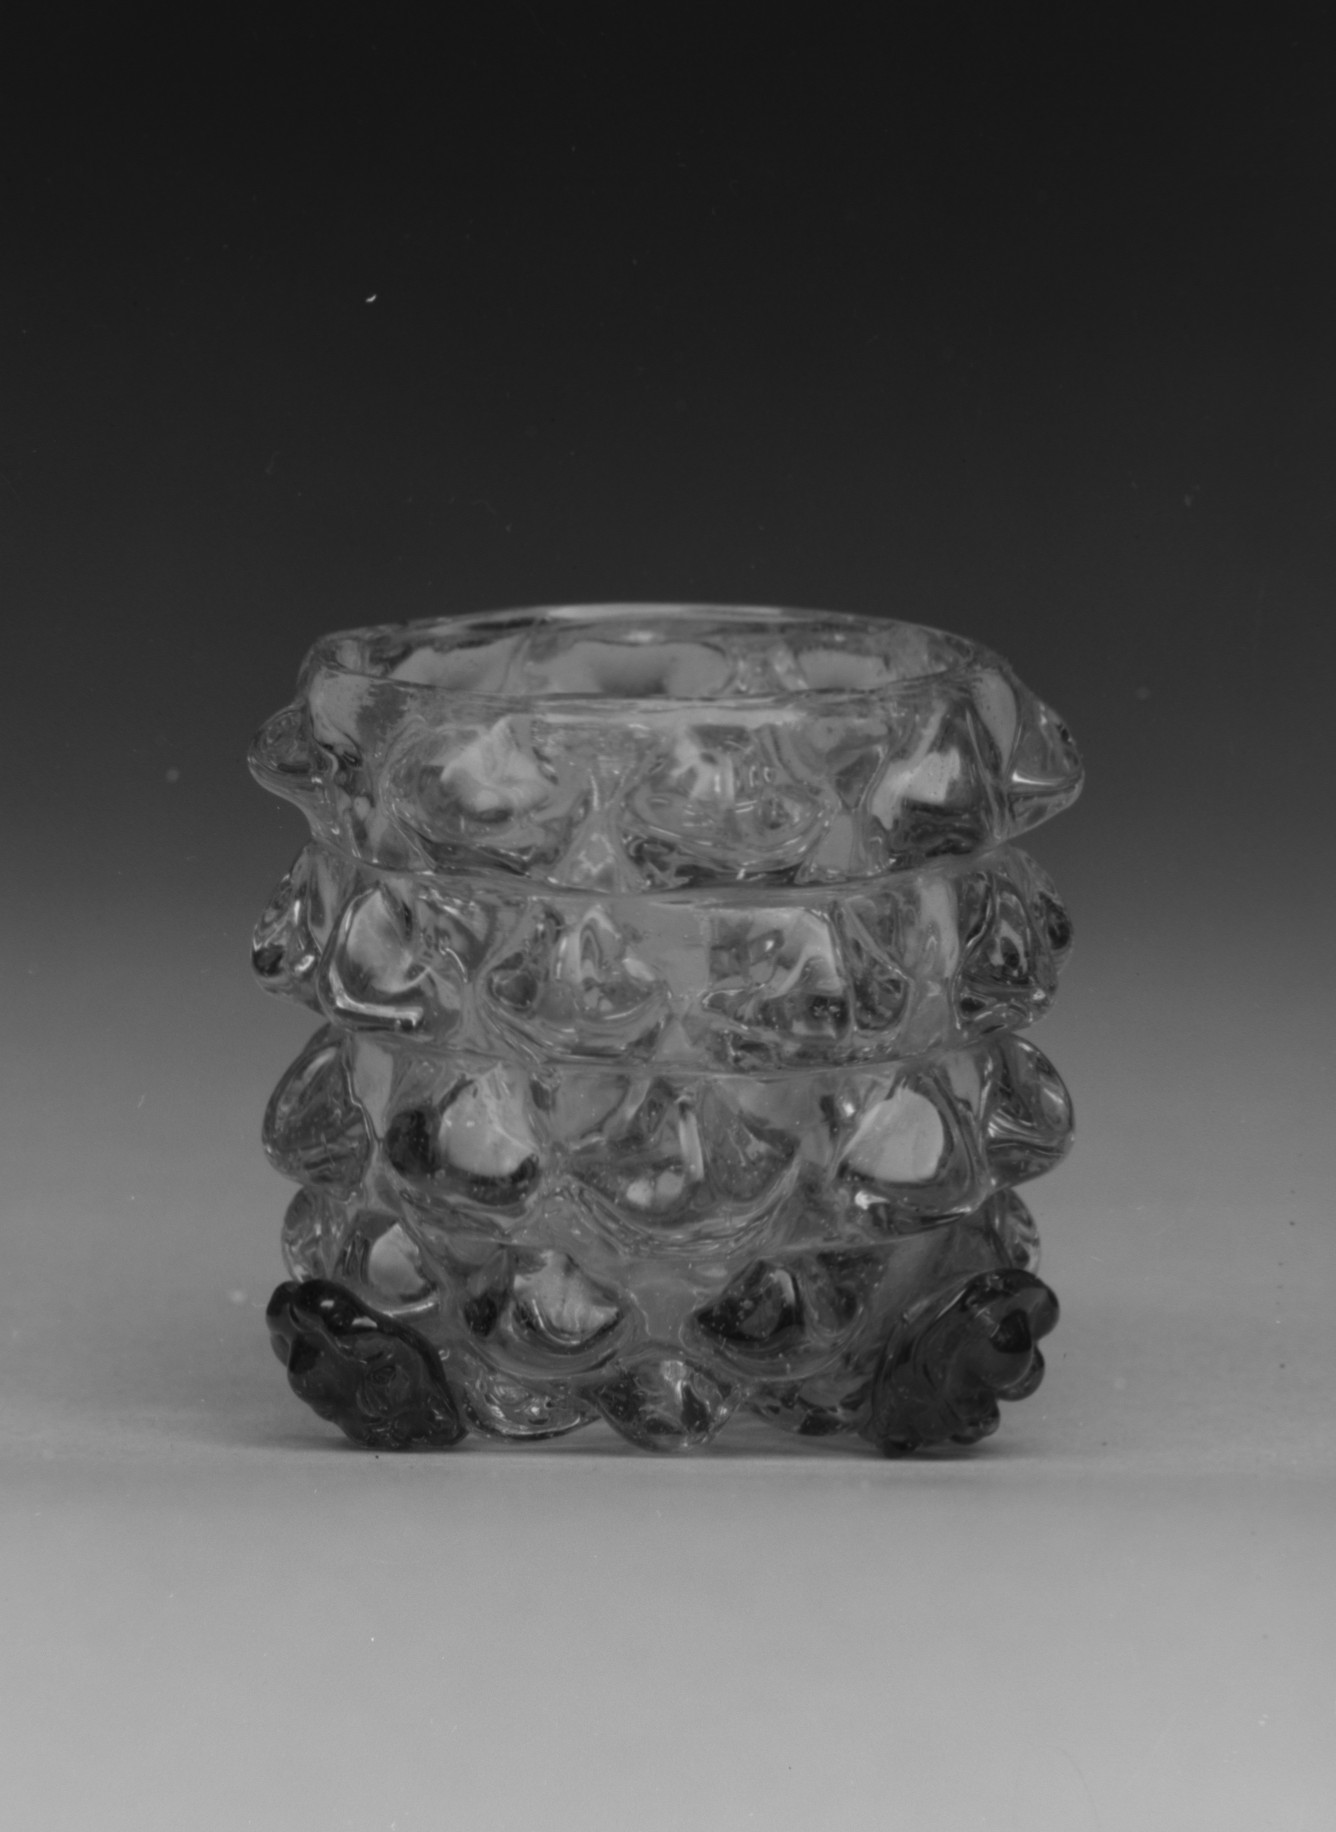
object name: bowl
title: Miniature bowl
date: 1567-1633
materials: glass